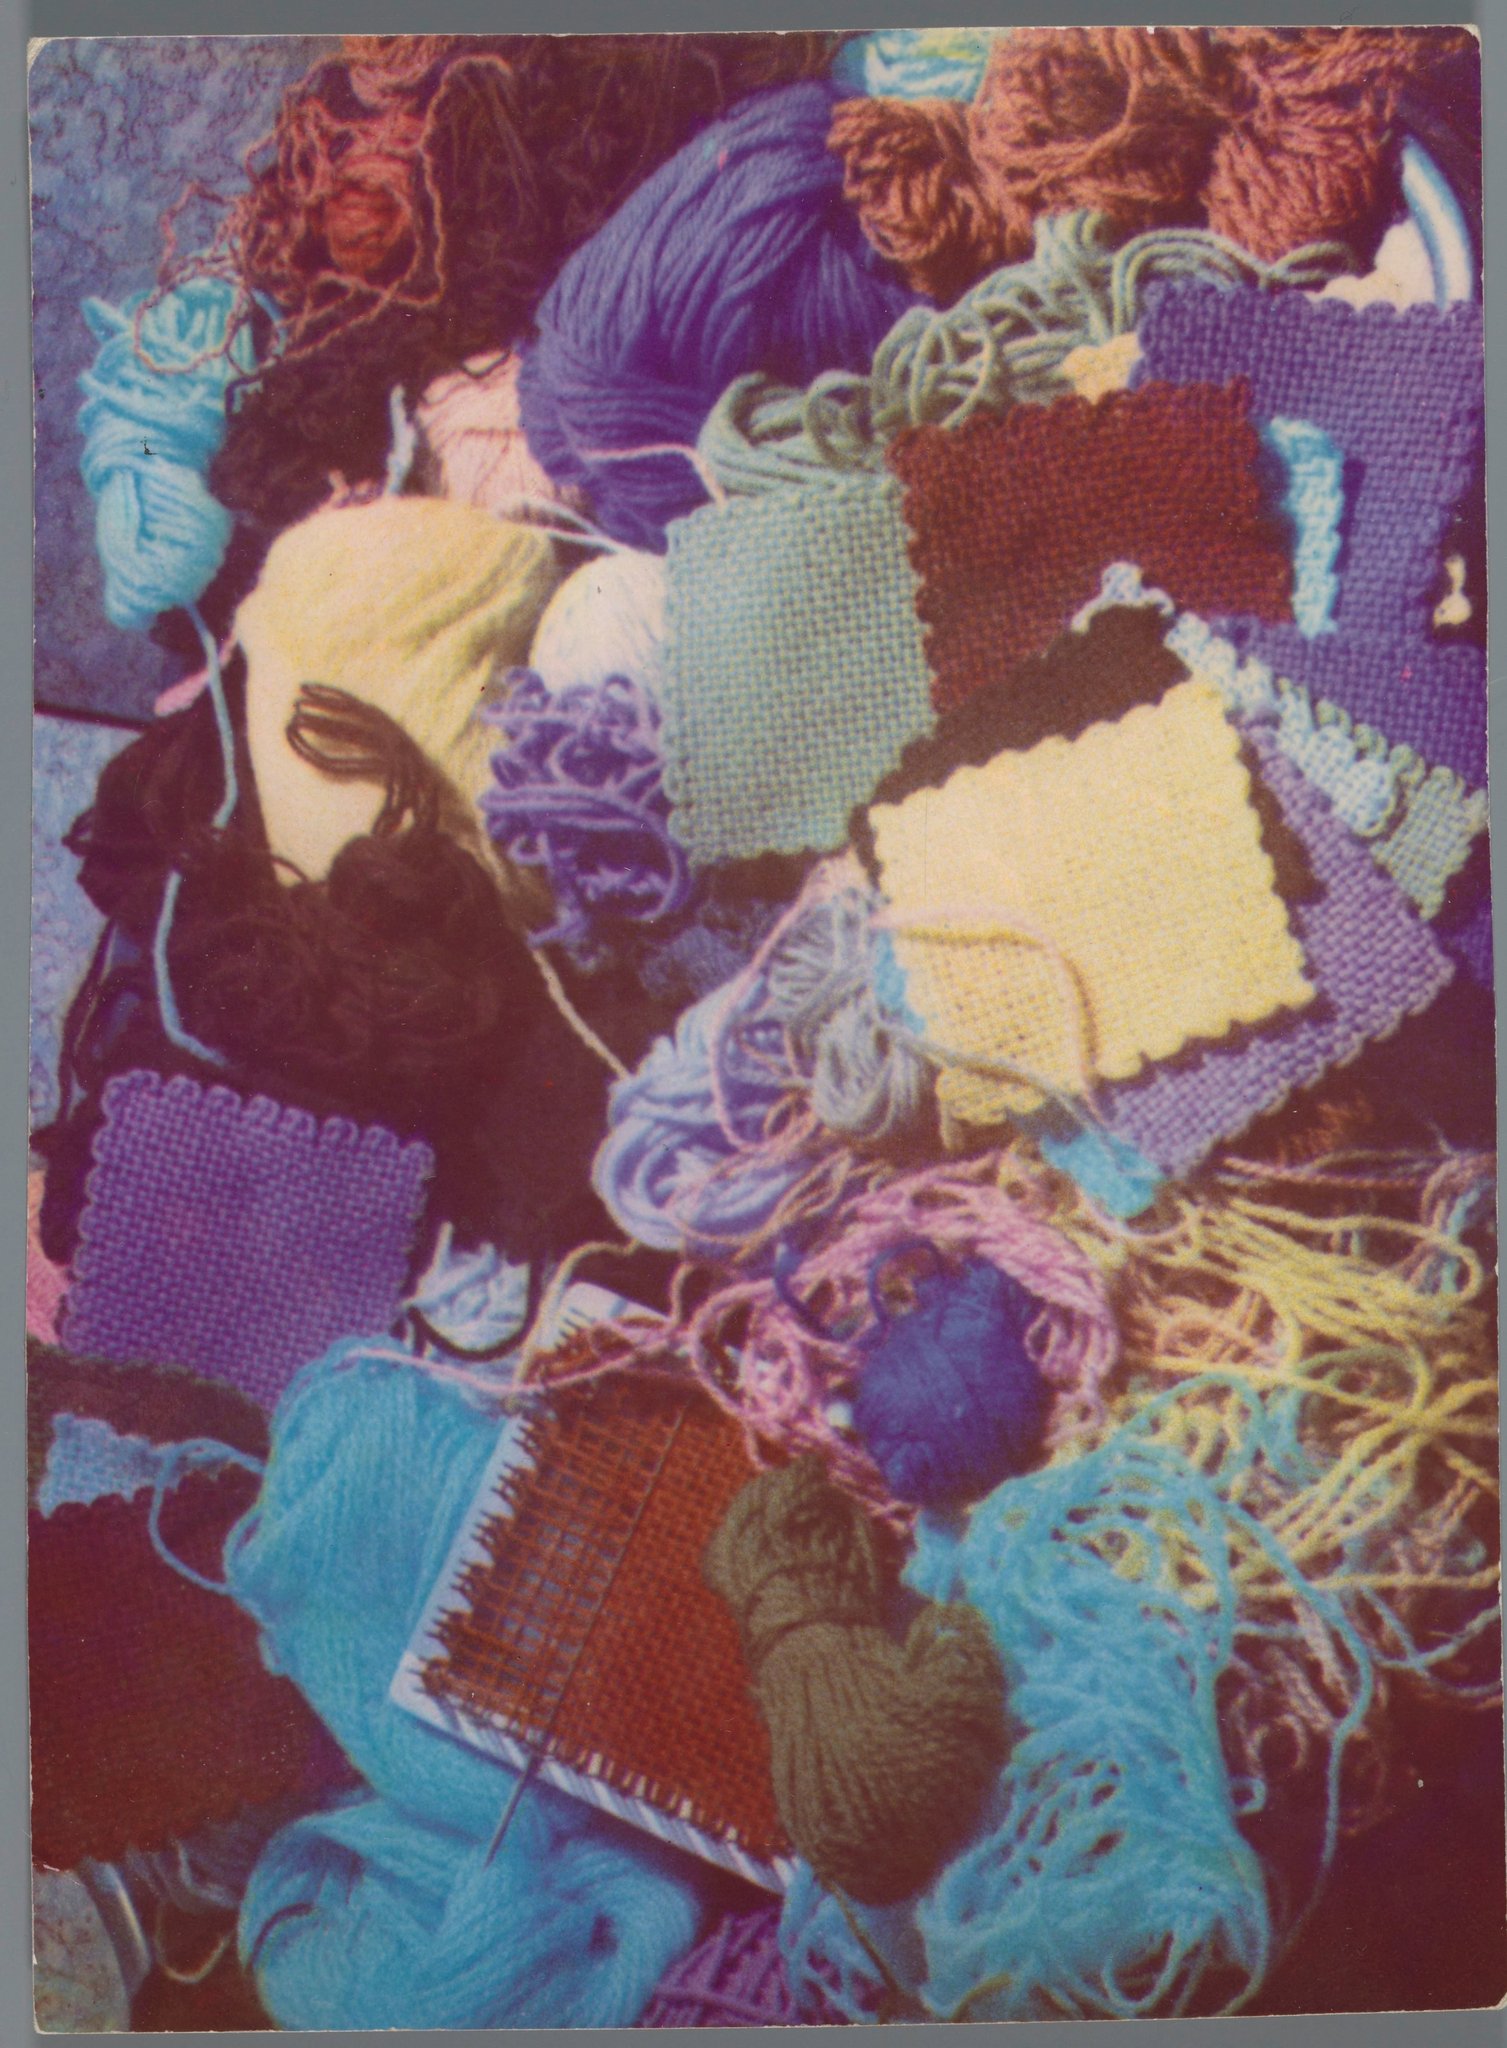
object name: photograph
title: Stilleven met wol en breinaalden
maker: Anonymous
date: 1930-1940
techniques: imbibition process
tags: (ball of) yarn, knitting